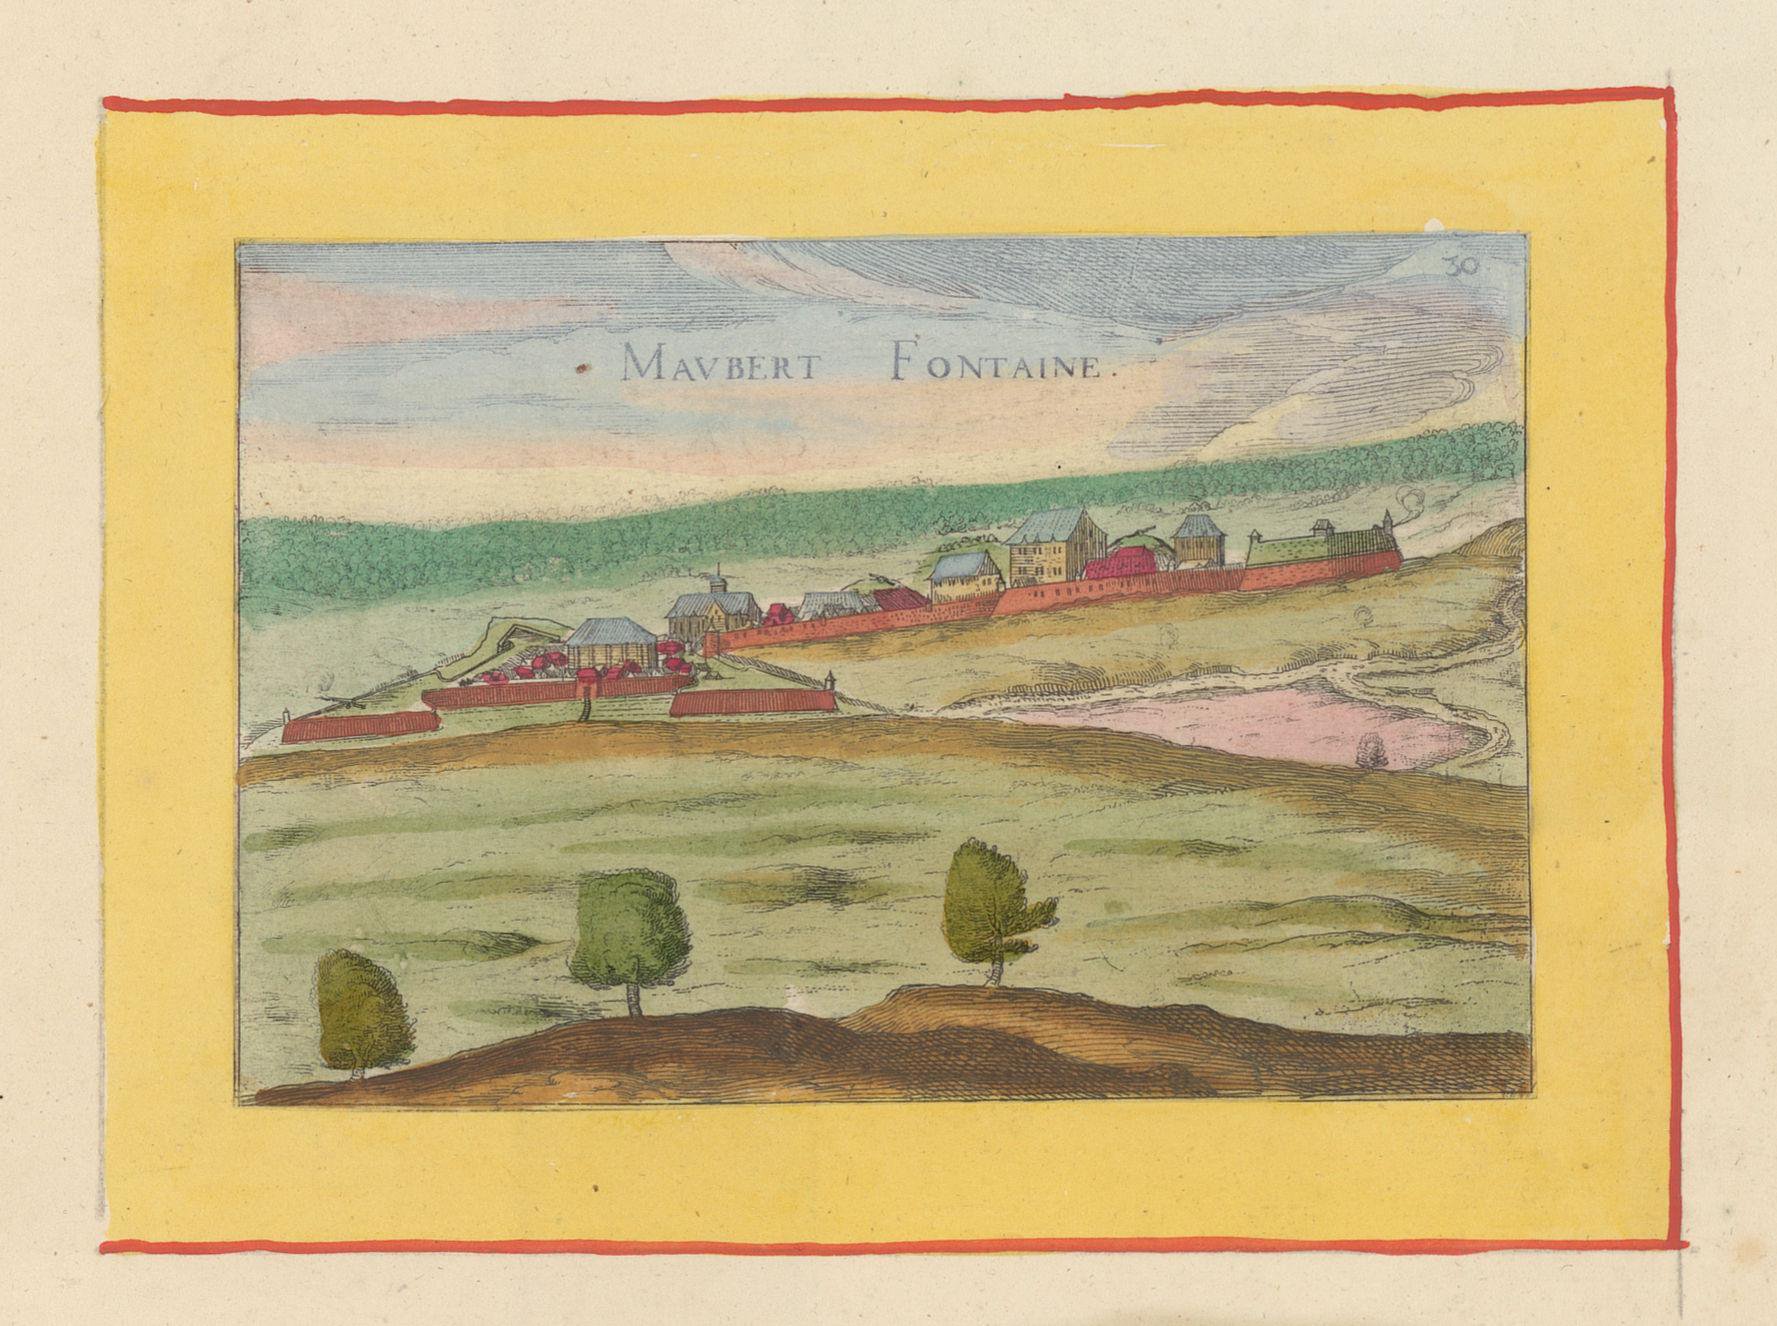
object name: print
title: Maubert Fontaine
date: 1638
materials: paper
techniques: engraving, hand coloring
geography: the hague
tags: city-view in general; 'veduta'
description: Prent uit: Tassin, Christophe. Les plans et profils de toutes les principales villes et lieux considérables de France (...). Parijs: Michel van Lochom, 1638, plattegrond 30 uit het deel 'Champagne'.